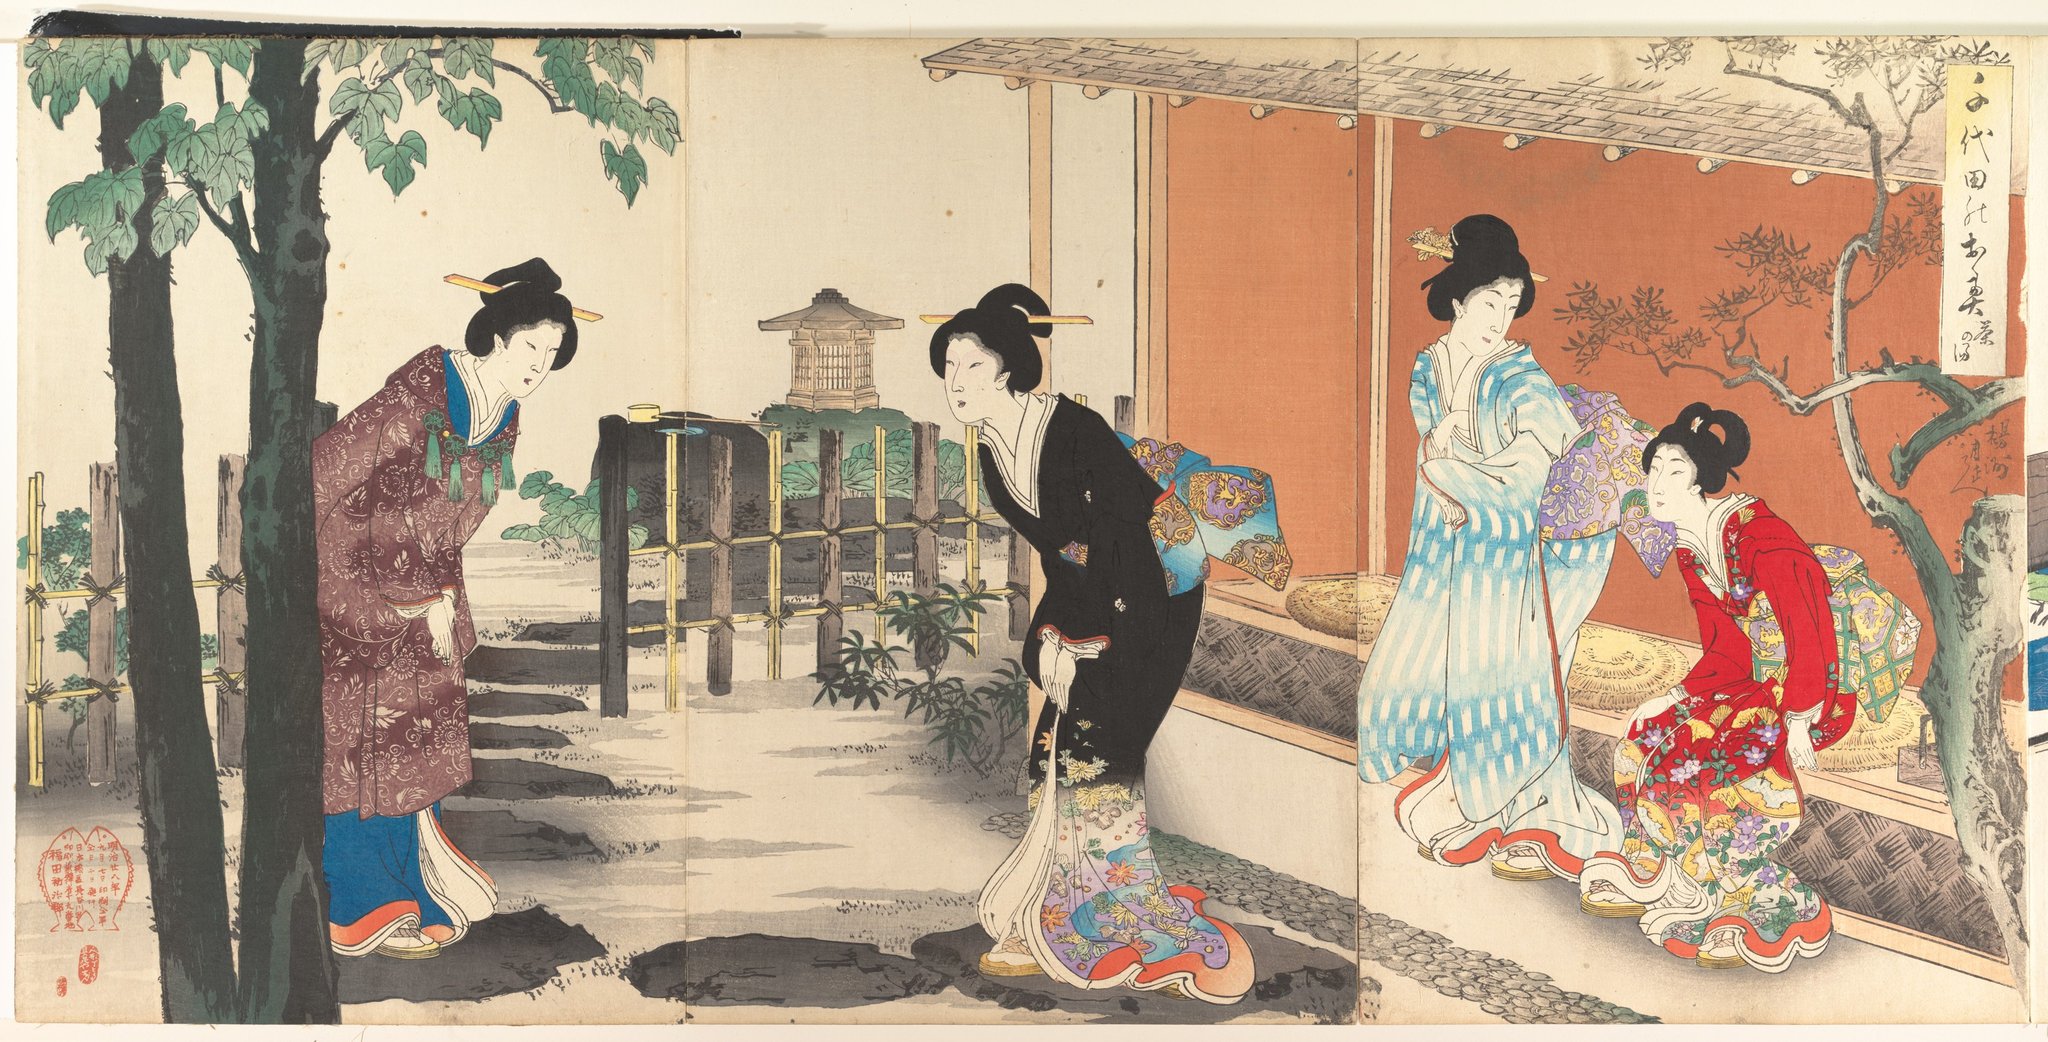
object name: print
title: Chiyoda Castle (Album of Women)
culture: japanese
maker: yōshū (hashimoto) chikanobu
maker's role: artist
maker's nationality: japanese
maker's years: 1838-1912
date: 1895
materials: ink, paper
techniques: woodblock print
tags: women,trees